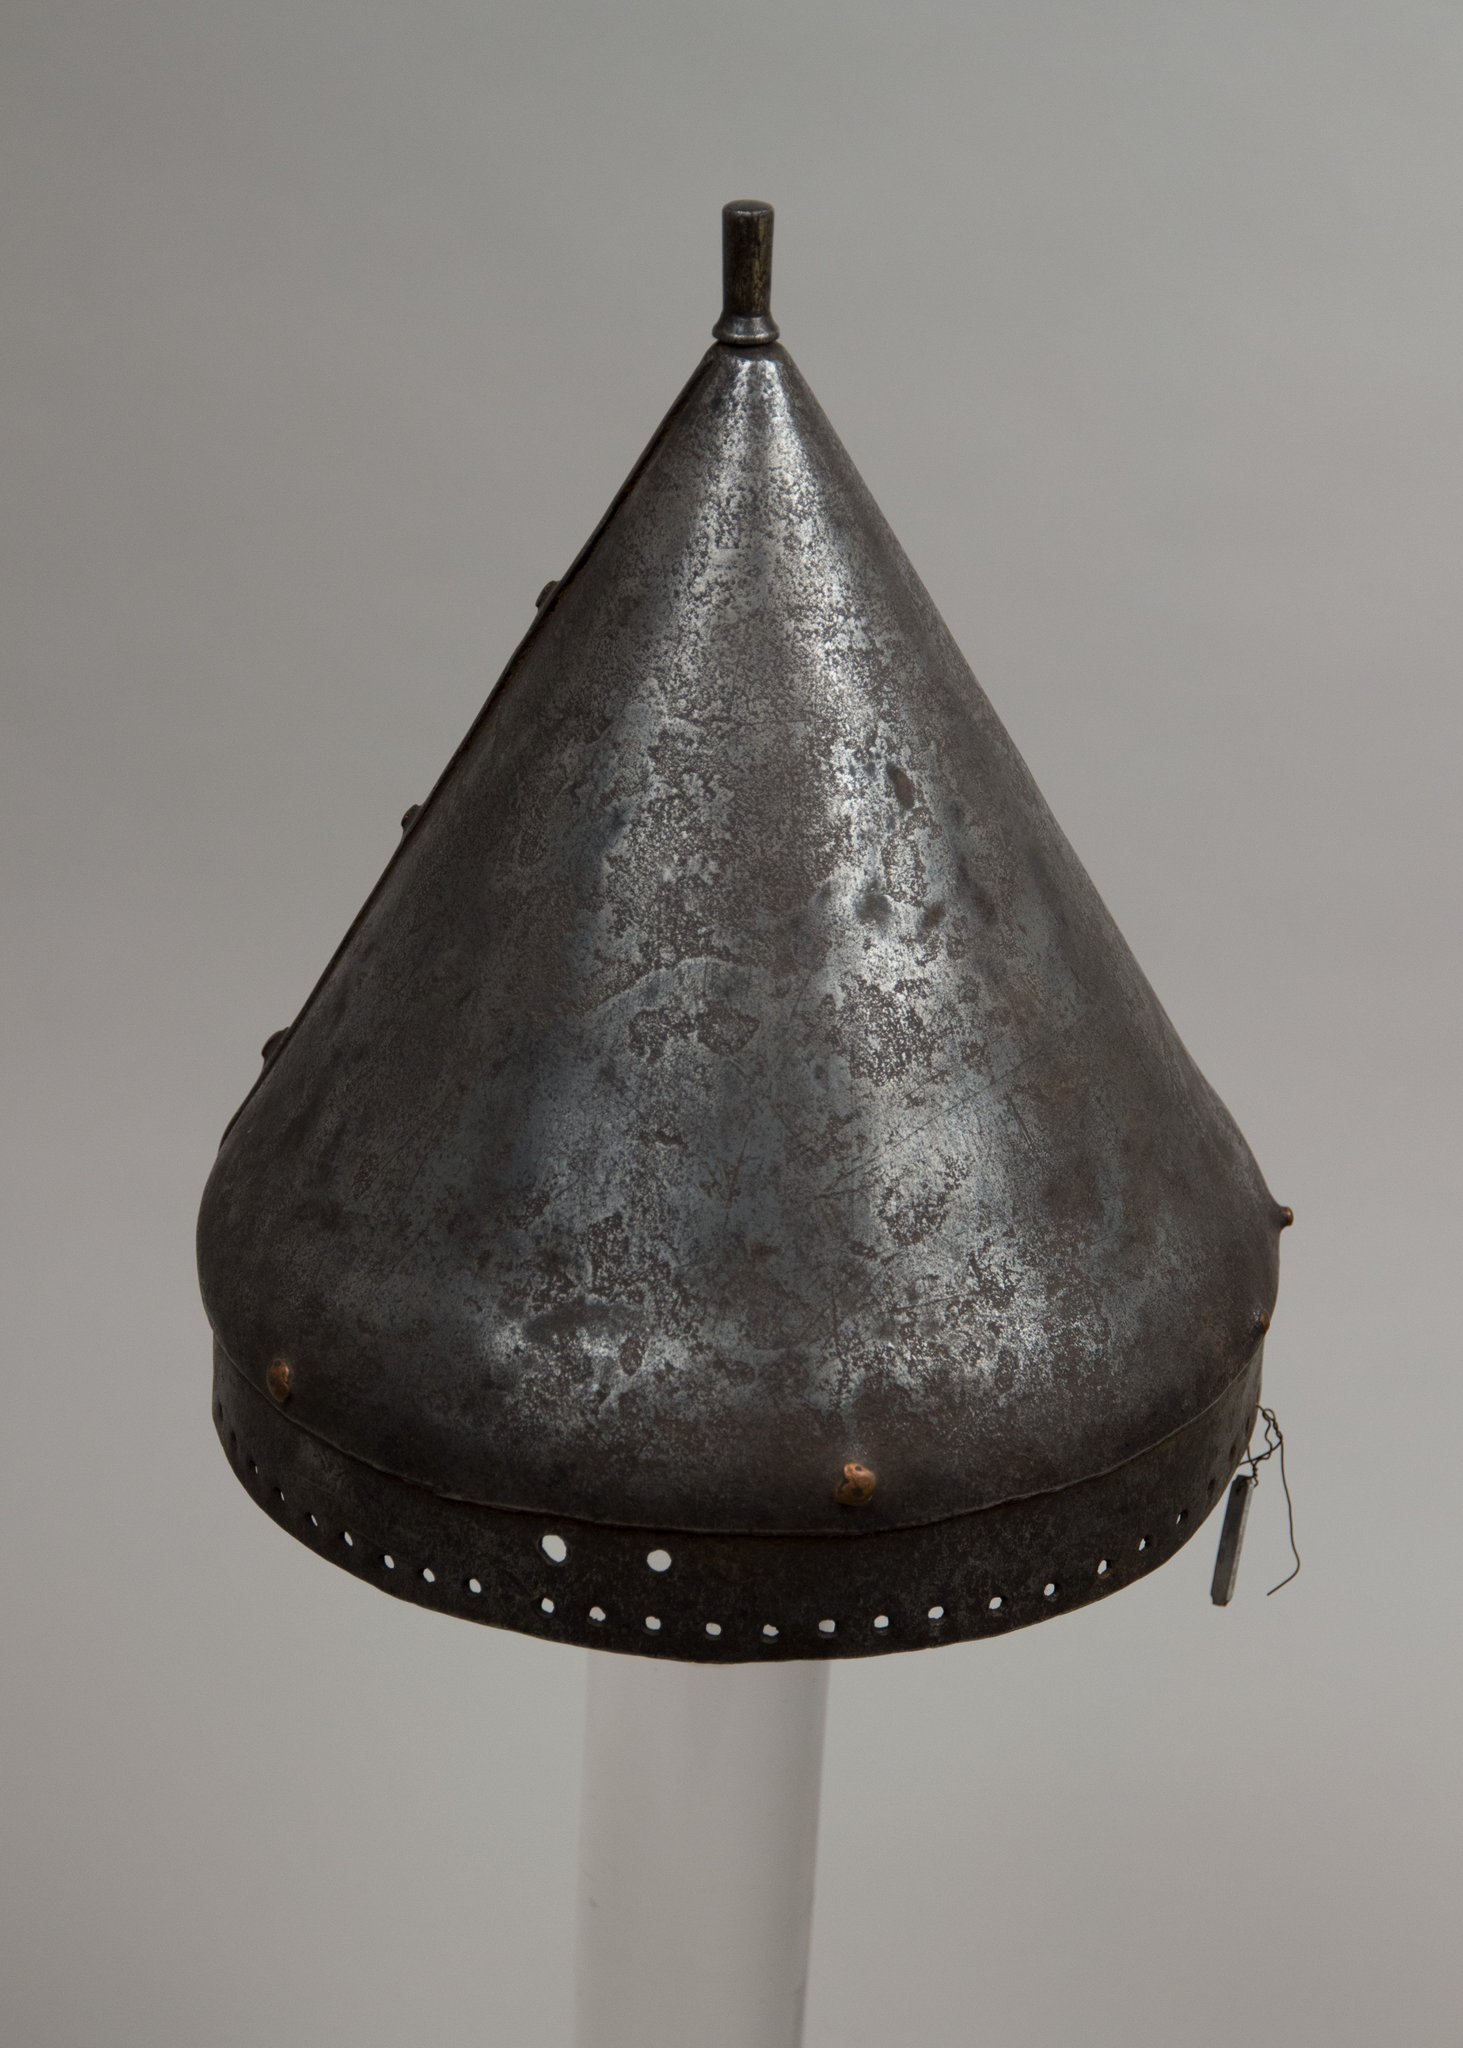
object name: helmet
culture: caucasian or russian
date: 1601-1700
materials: copper, steel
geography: caucasus